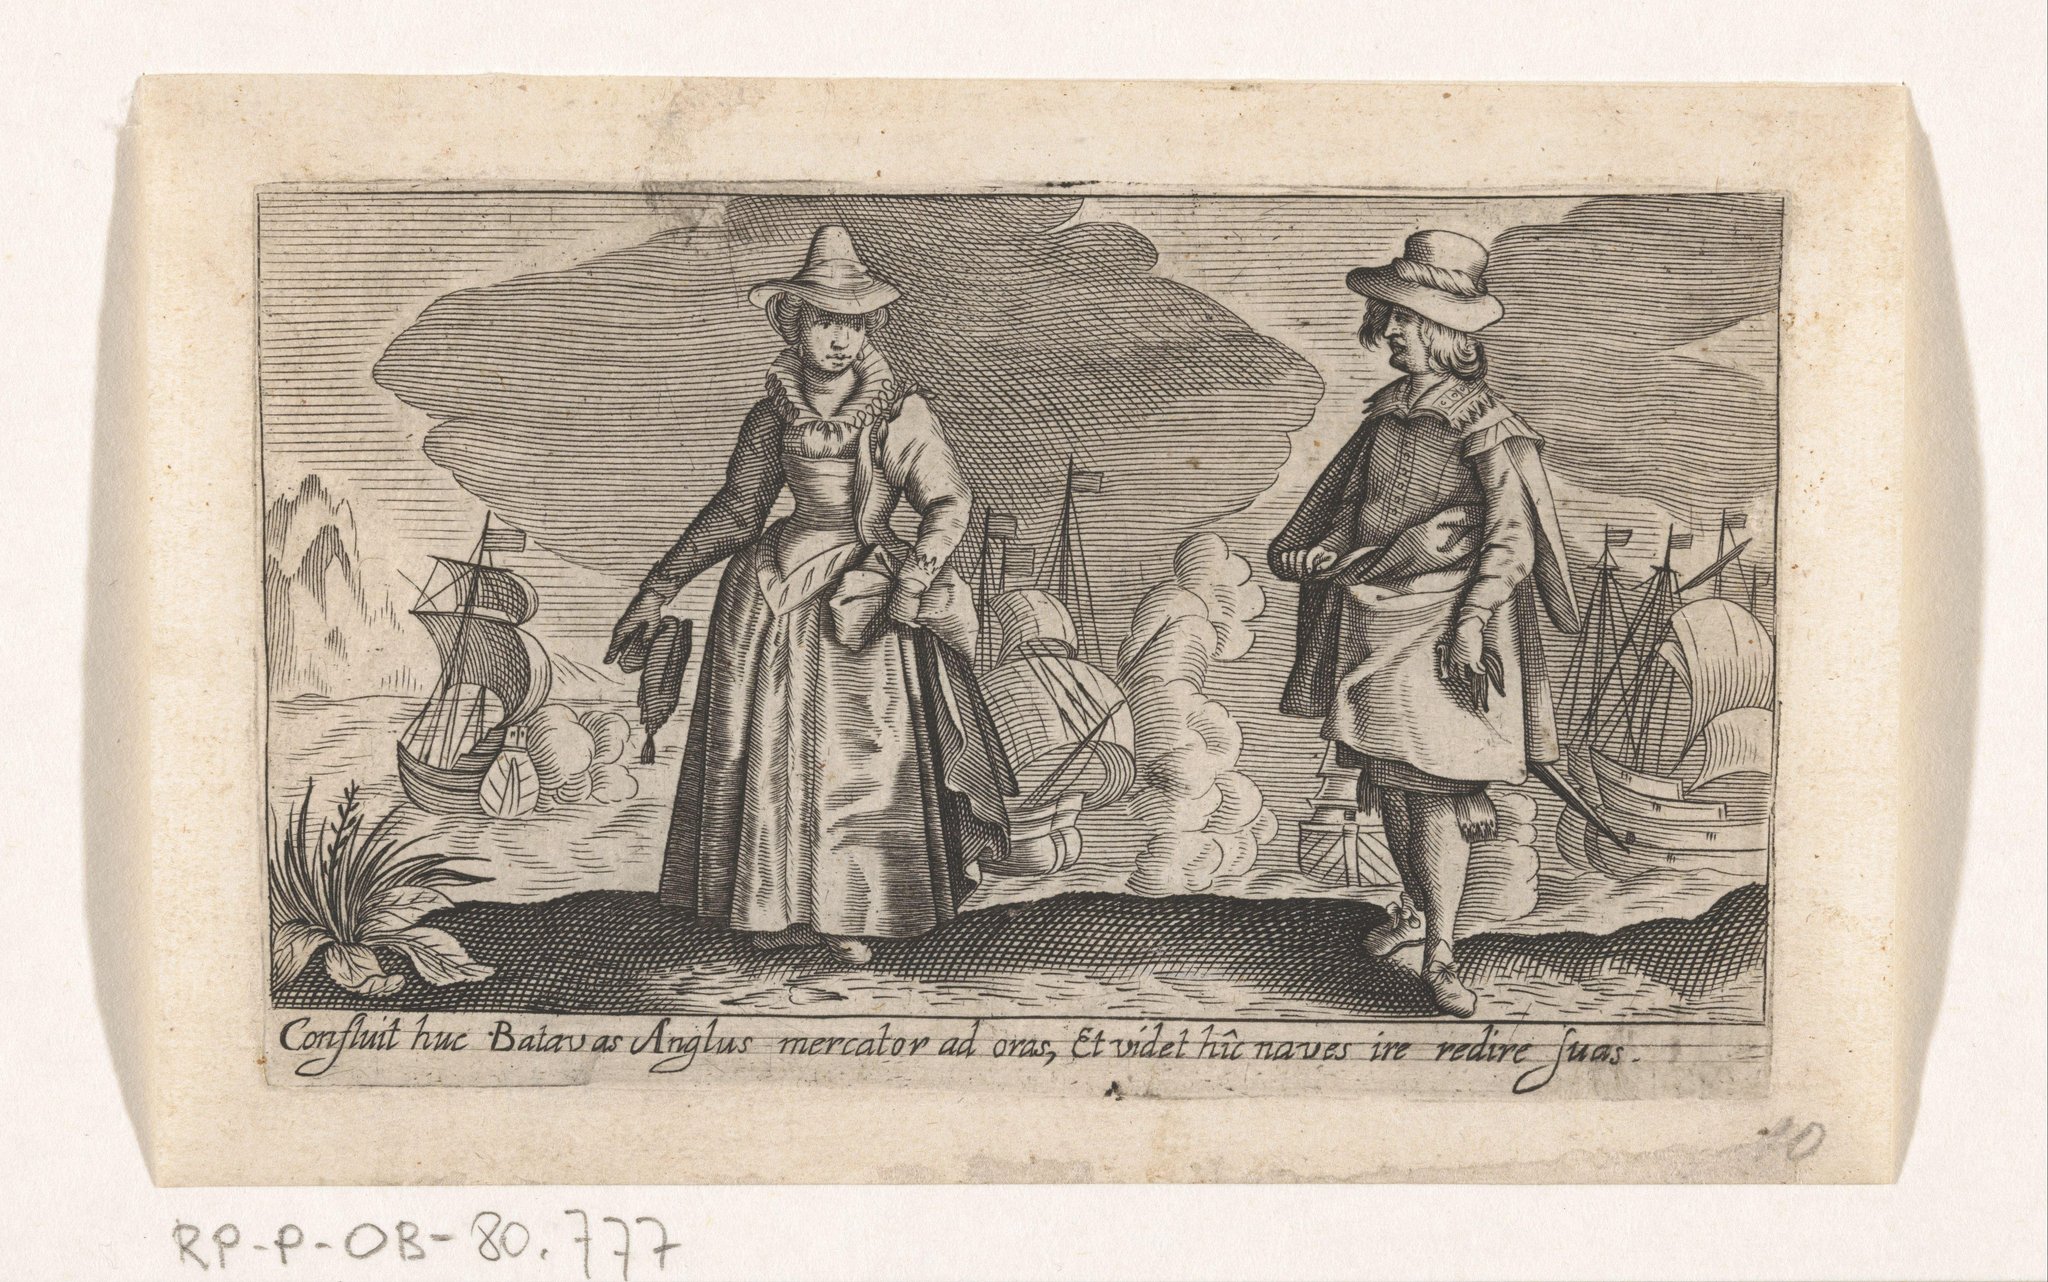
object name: print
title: Zeevaart, ca. 1610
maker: Anonymous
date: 1611-1613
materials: paper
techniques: engraving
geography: northern netherlands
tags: battle (+ naval force)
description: Zeevaart, ca. 1610. Een elegant paar staande op het land,. op de achtergrond een zeeslag. Met onderschrift van 2 regels in het Latijn.